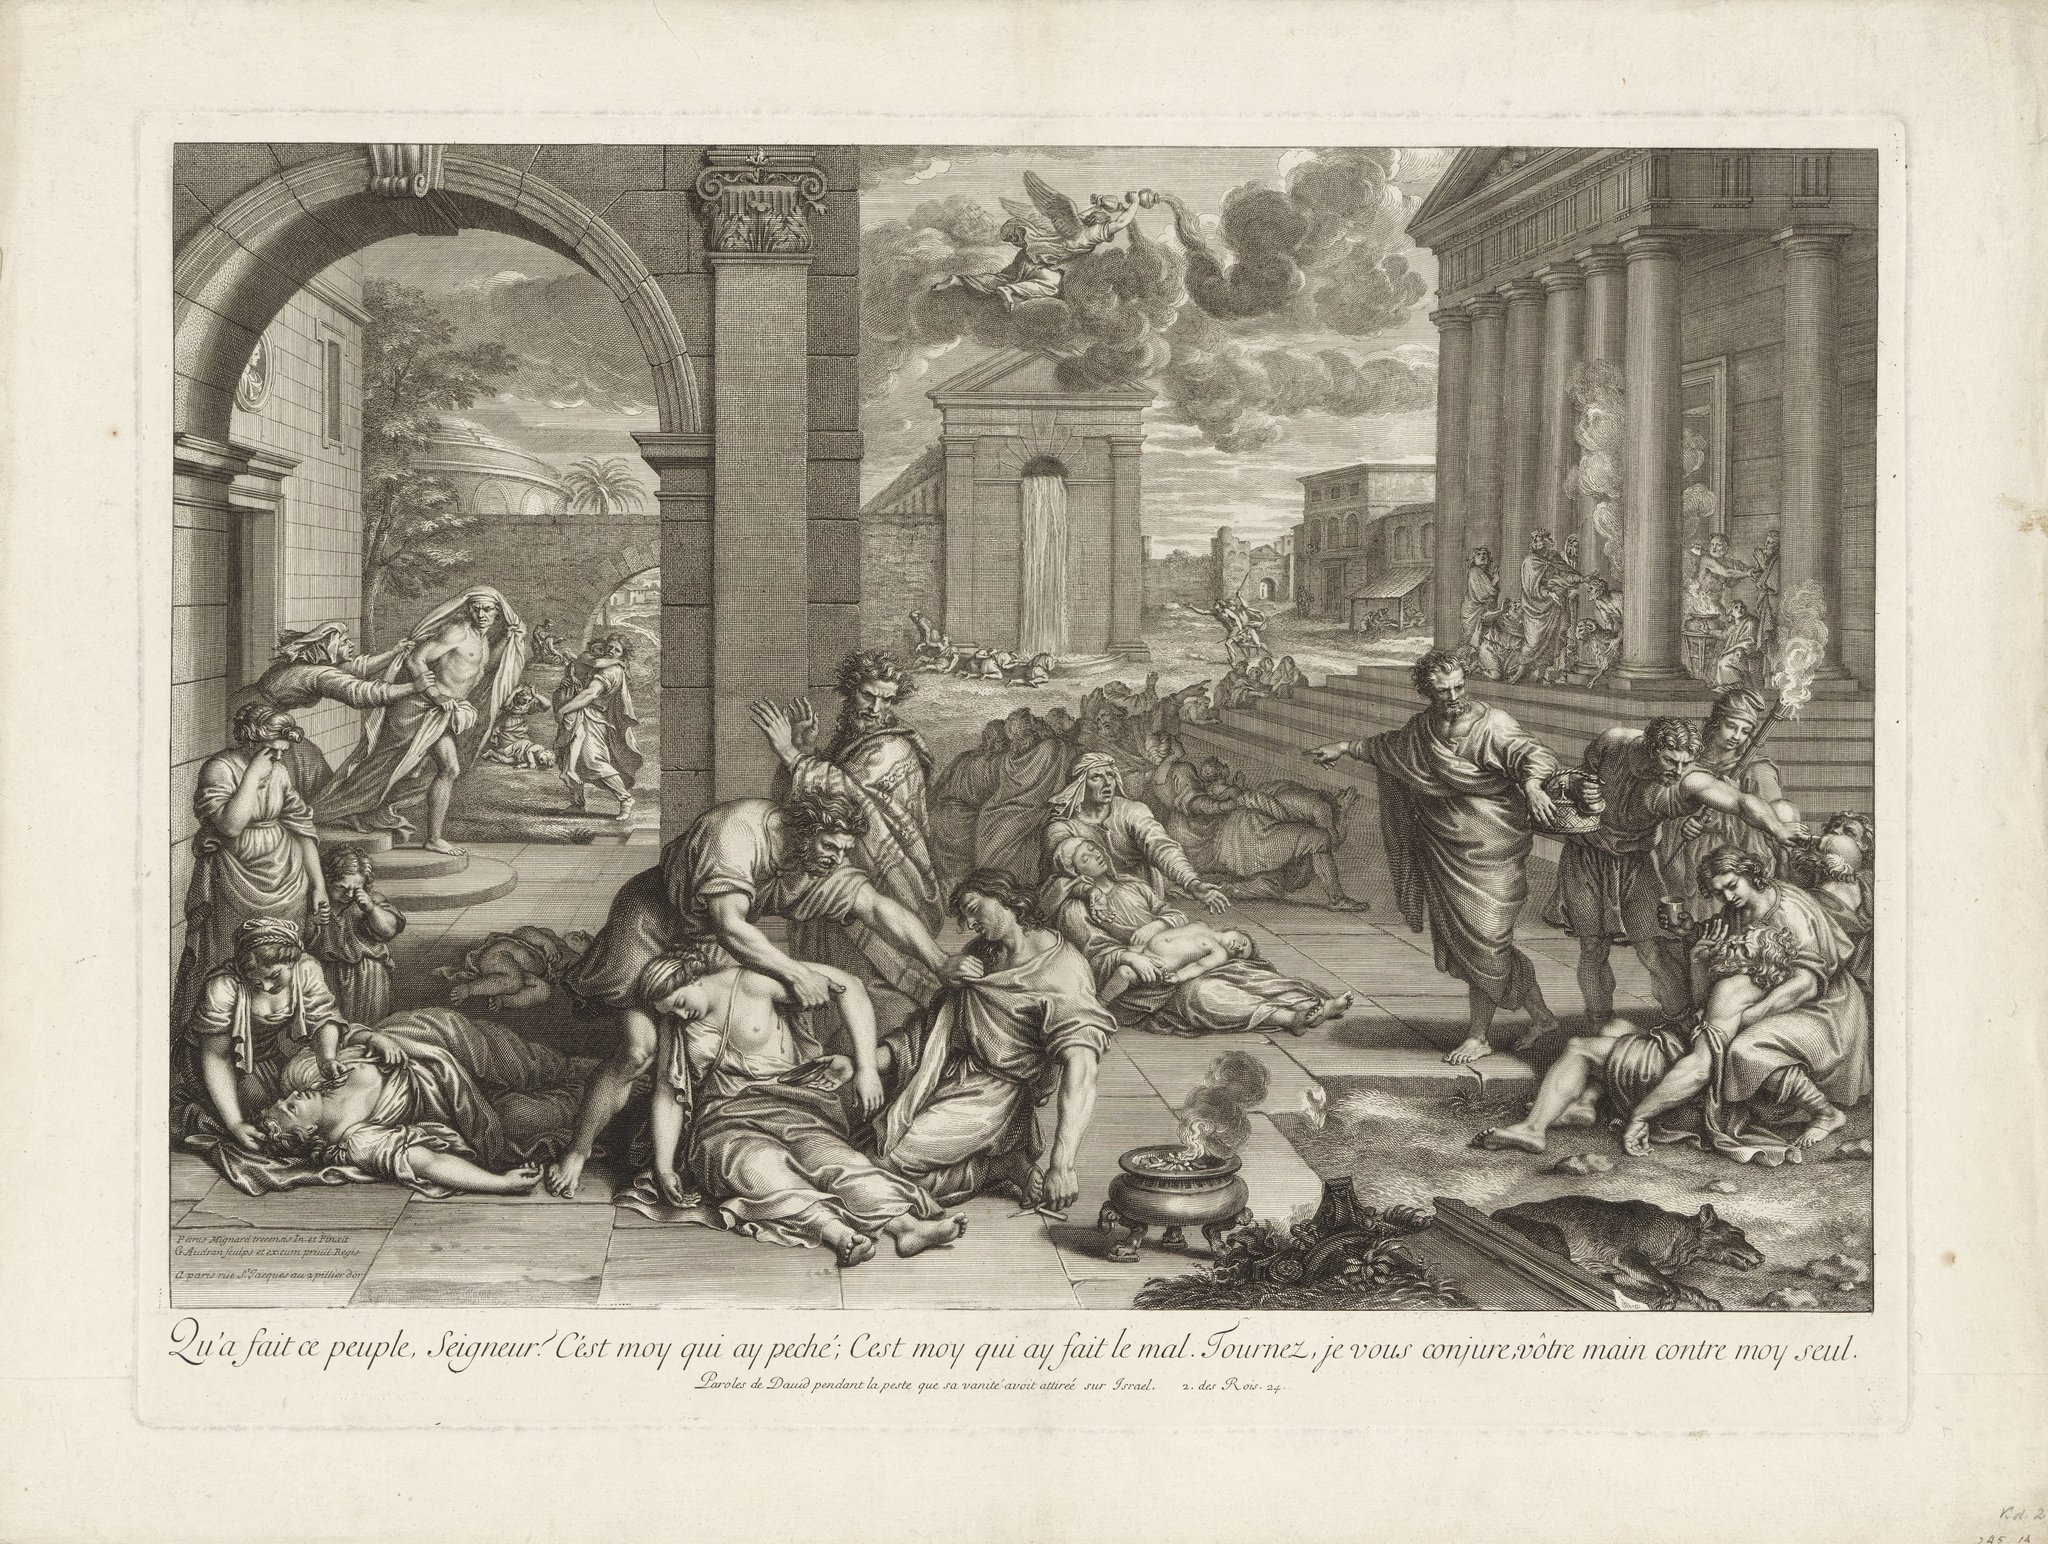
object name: print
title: Paroles de David pendant la peste que sa vanité avoit attirée sur Israel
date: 1650-1703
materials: paper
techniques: engraving, etching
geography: france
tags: god punishes israel with three days of plague; the avenging angel with his sword drawn goes through the land; seventy thousand men are killed, plague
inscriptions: collector's mark: Lugt 240, collector's mark: Lugt 1838